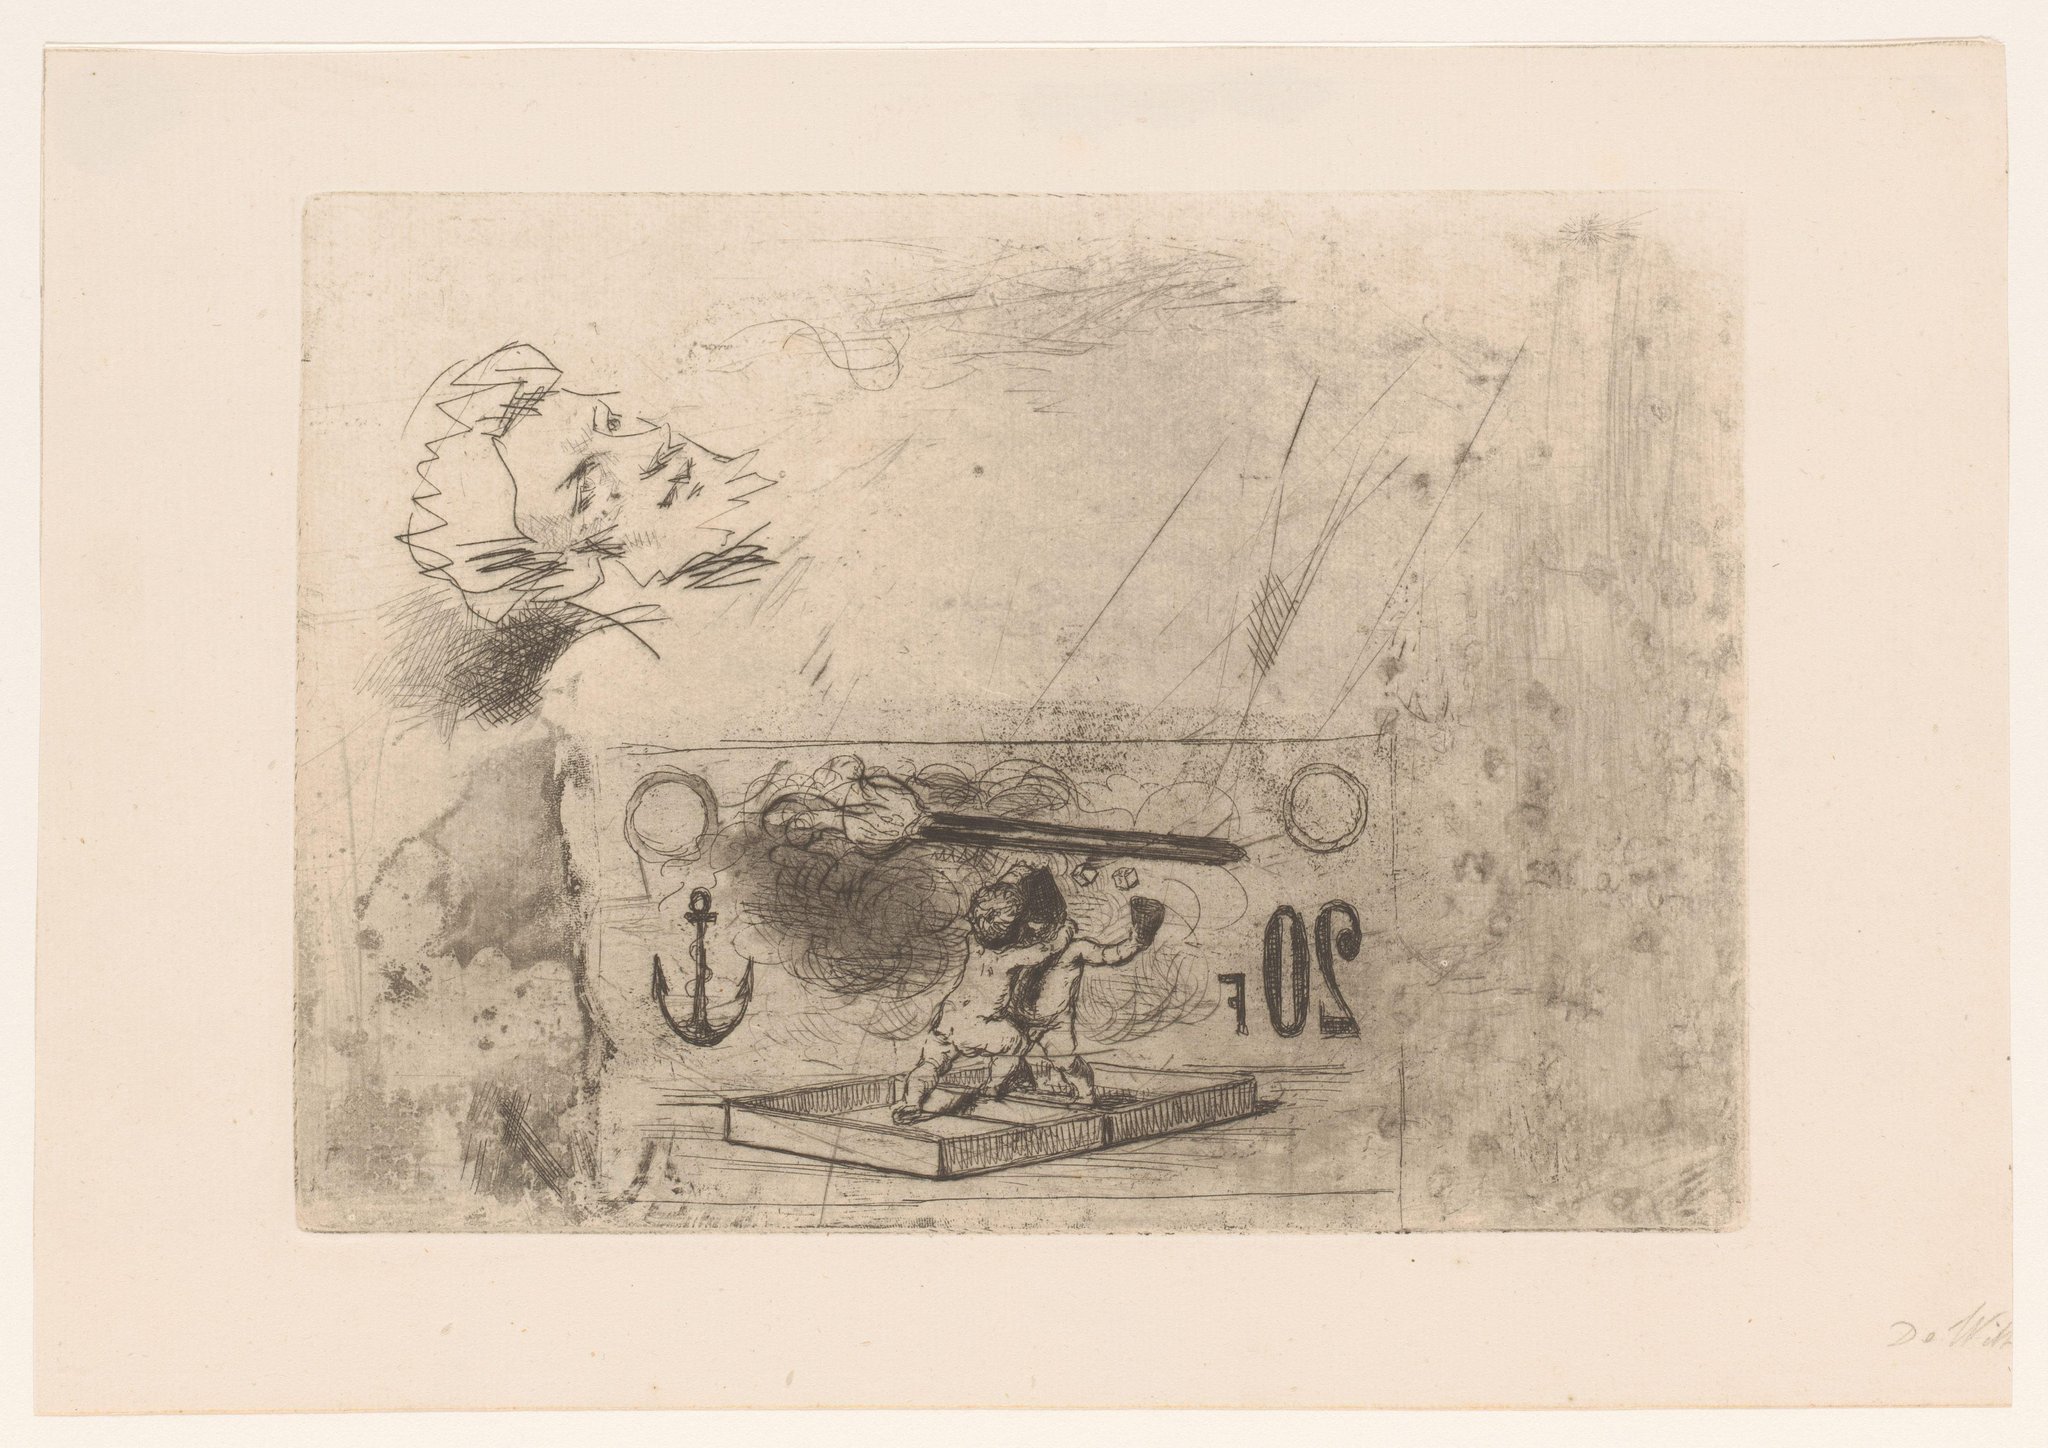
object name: print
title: Studieblad met onder andere putti, een fakkel, anker en hoofd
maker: adrien de witte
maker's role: print maker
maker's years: 1850-1935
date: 1860-1913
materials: paper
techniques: etching, intaglio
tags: torch, parts of ship's exterior: anchor, cupids: 'amores', 'amoretti', 'putti'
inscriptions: collector's mark: Lugt 2228